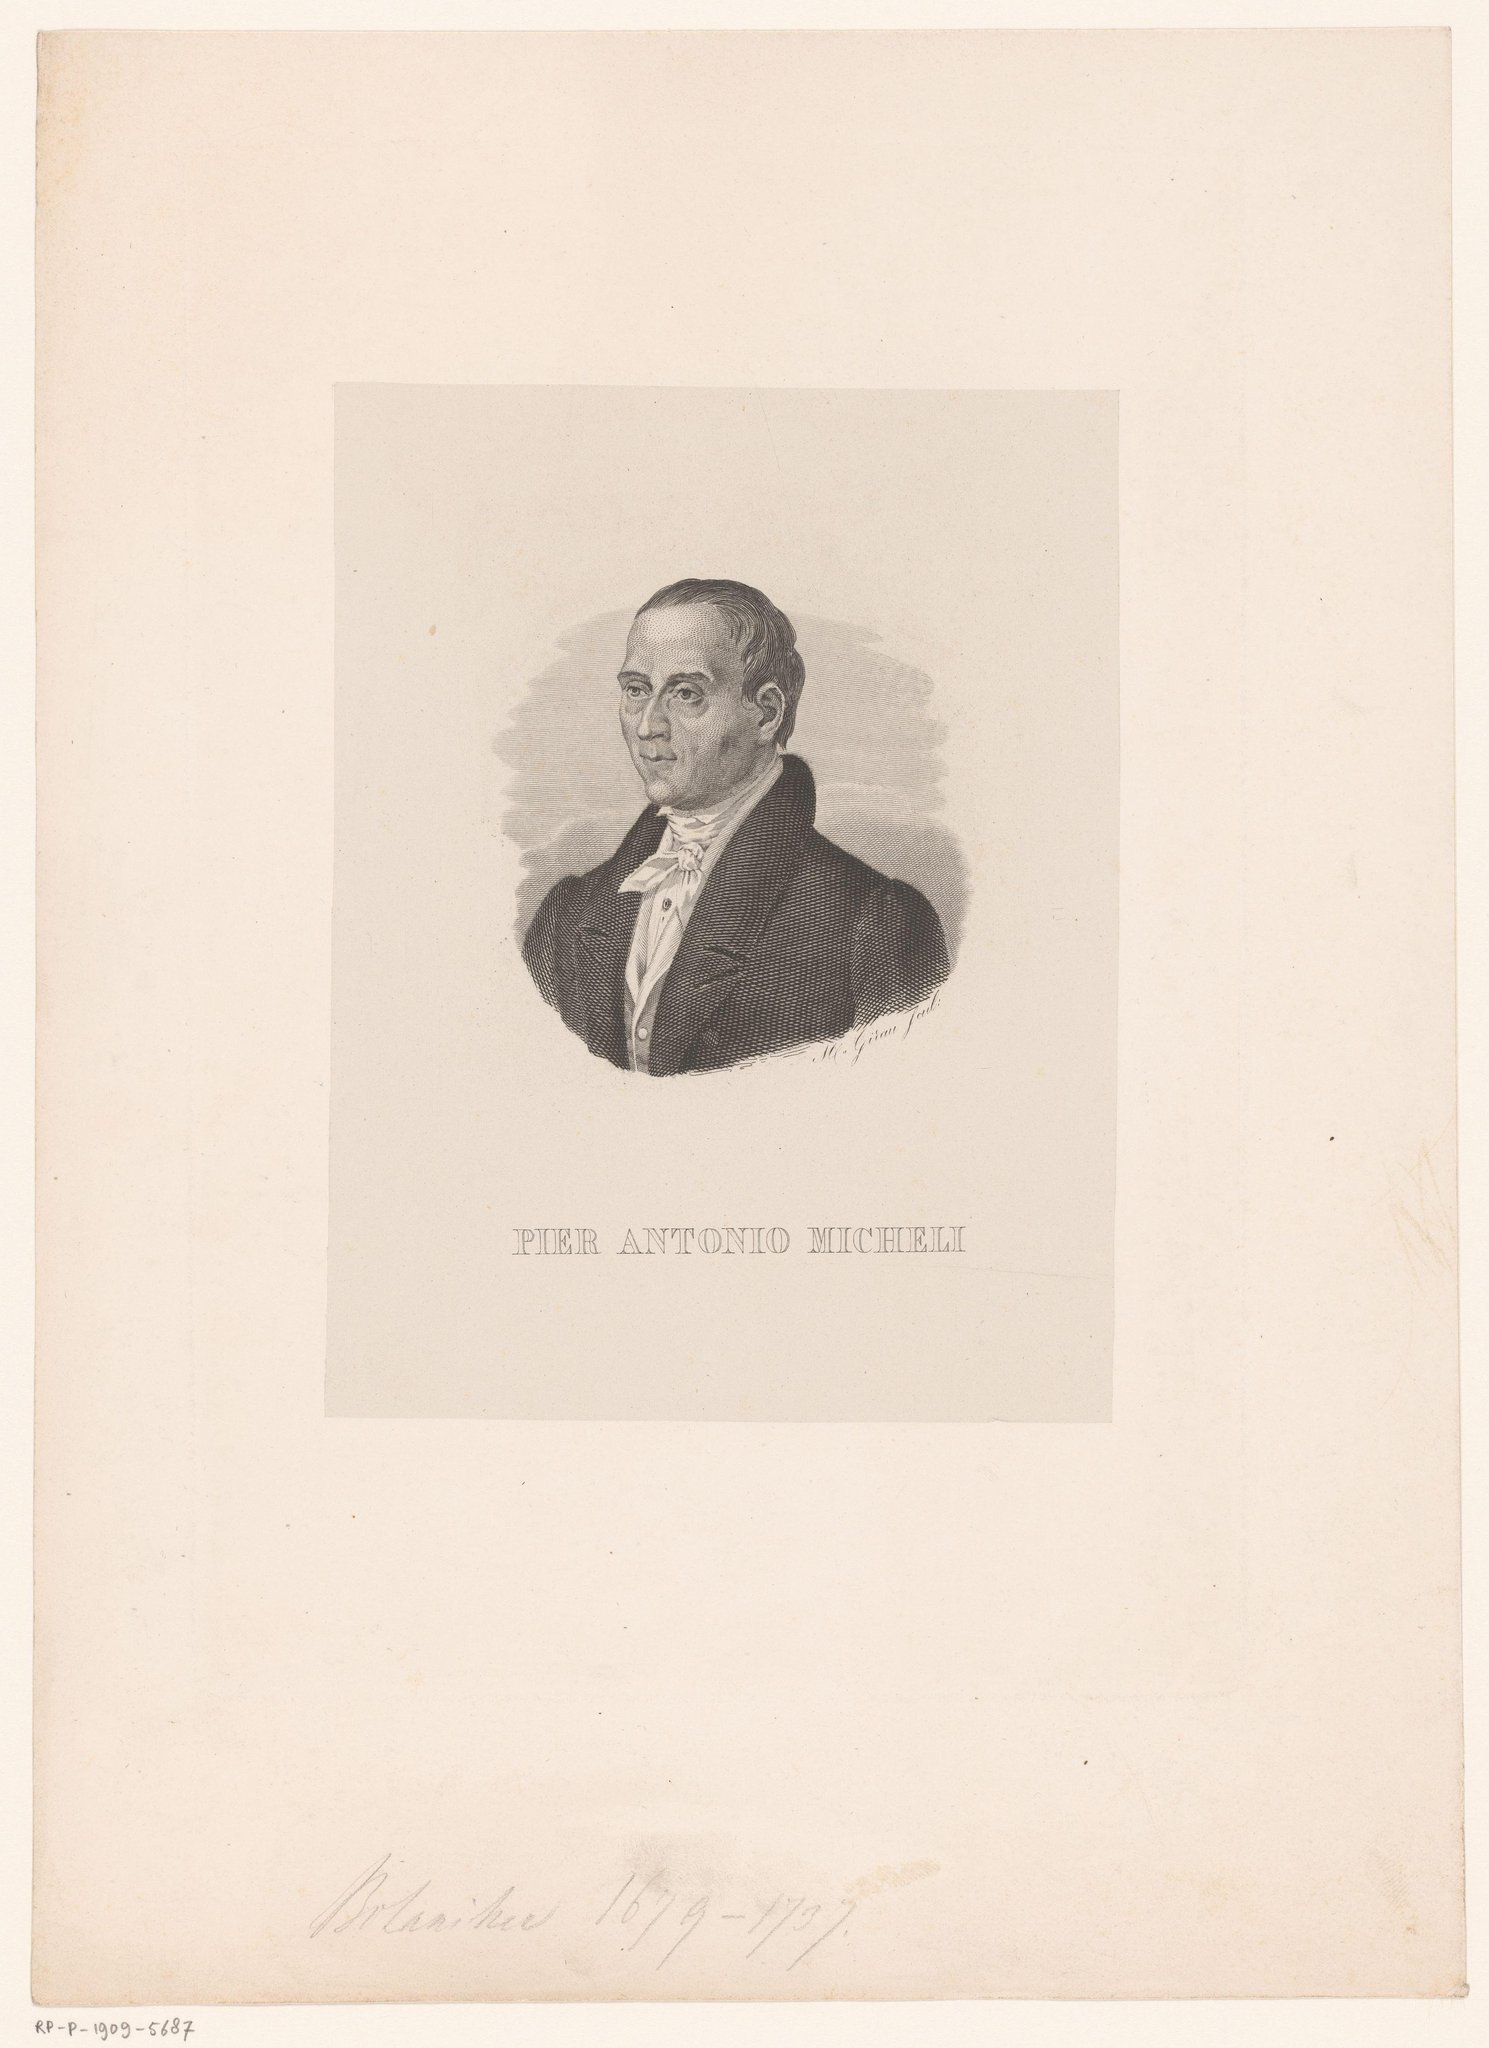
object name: print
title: Portret van Pier Antonio Micheli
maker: m. girau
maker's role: print maker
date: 1800-1899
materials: paper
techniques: engraving, etching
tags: historical persons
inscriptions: collector's mark: Lugt 2228